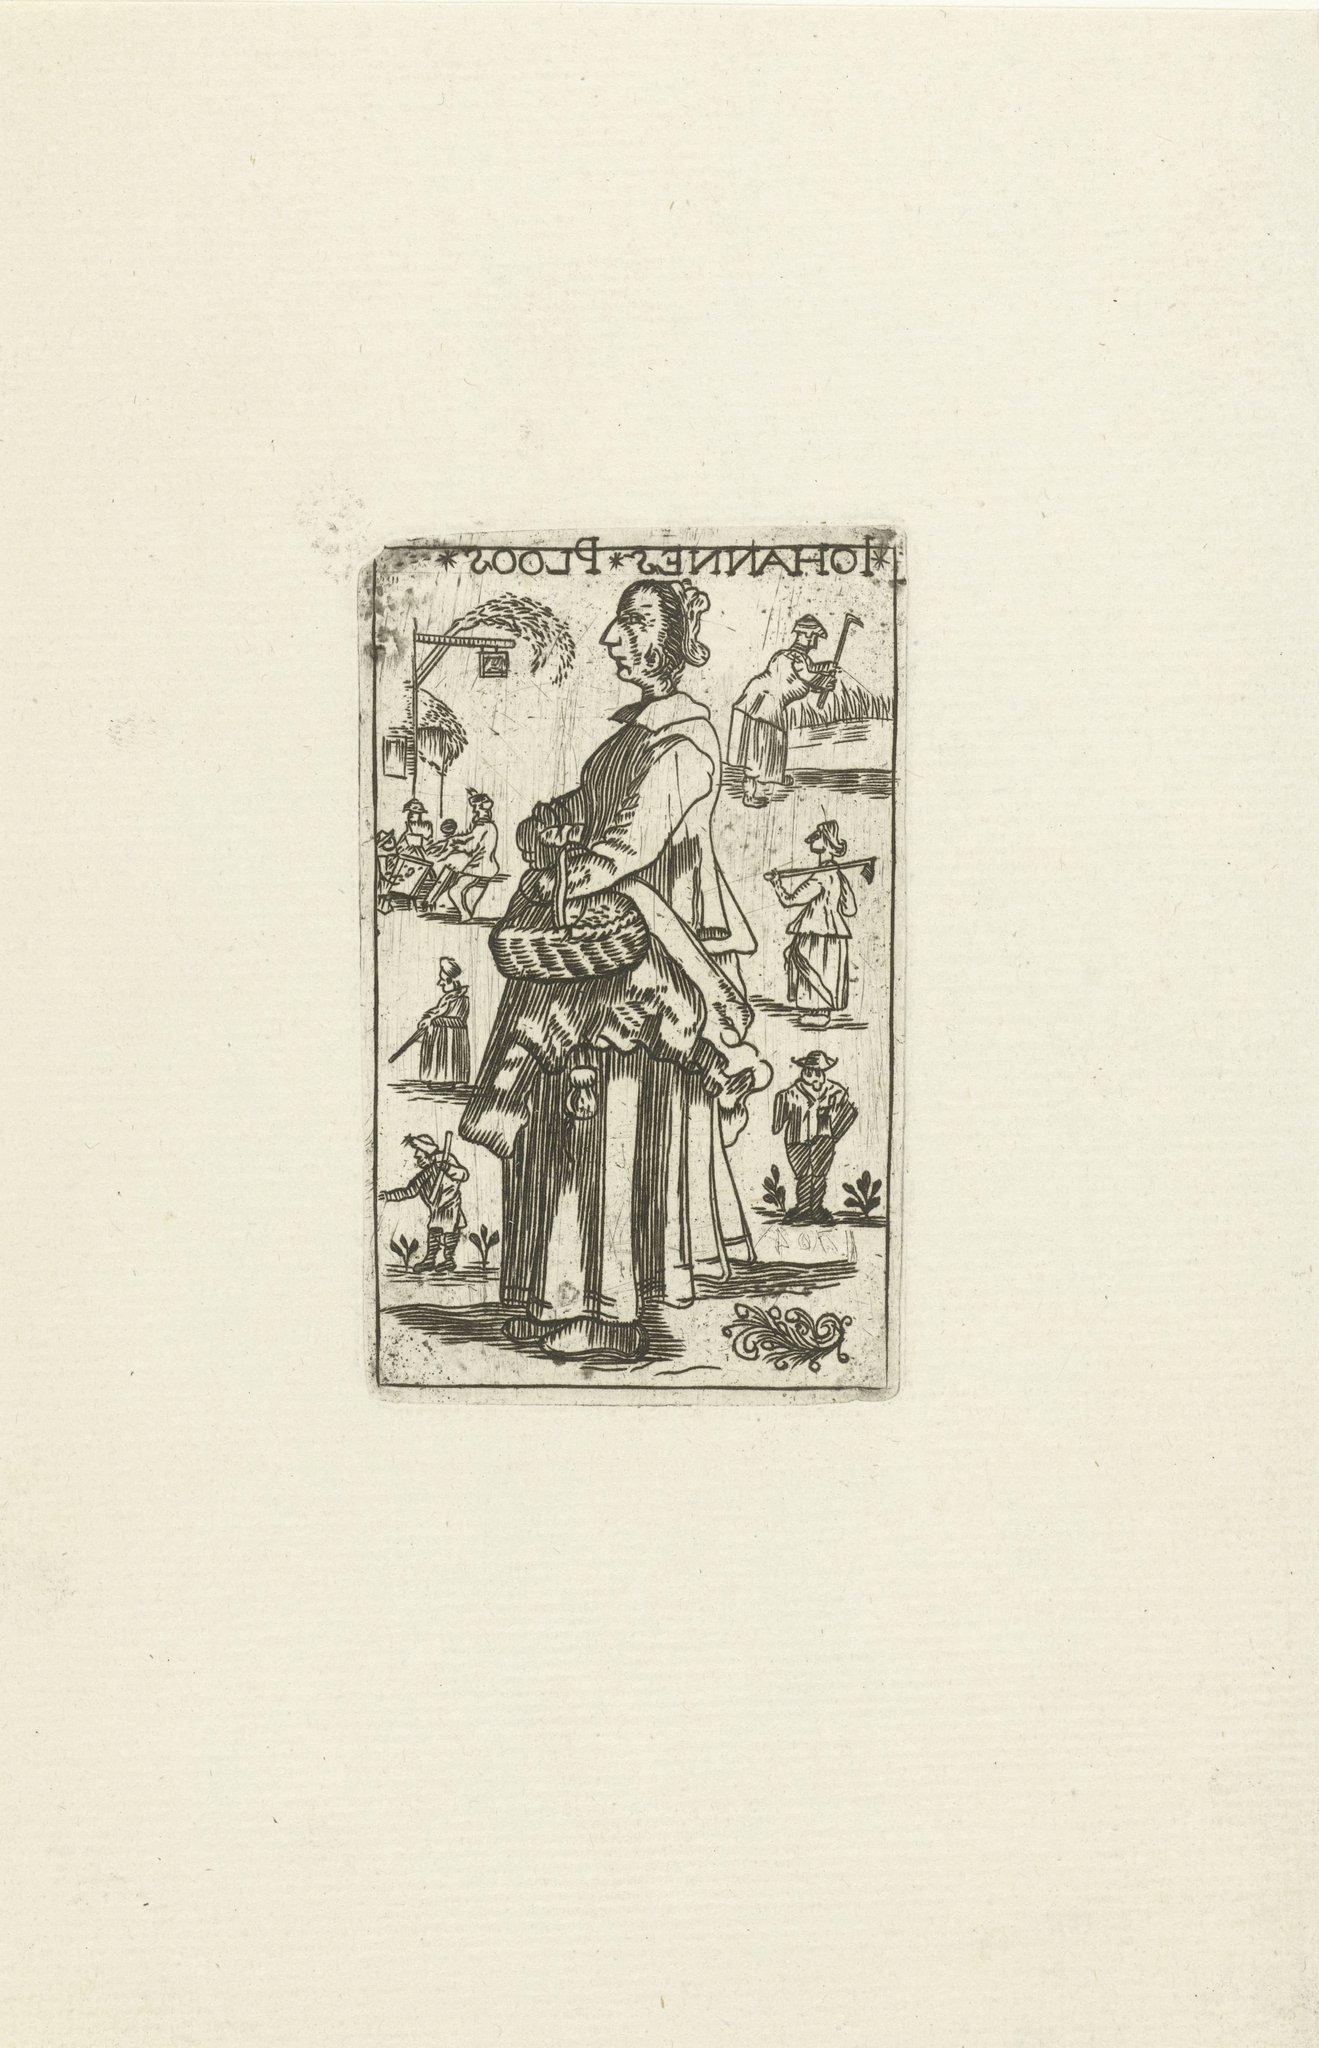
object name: print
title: Boerin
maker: johannes ploos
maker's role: print maker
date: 1704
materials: paper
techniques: etching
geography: northern netherlands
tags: farmers - aa - female farmer, farmer's wife, agriculture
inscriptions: collector's mark: Lugt 2227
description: Boerin met een mand aan de arm. De voorstelling is omringd door boeren. Ze werken op de akker en in het veld. Bovenaan de naam van de kunstenaar in spiegelbeeld.